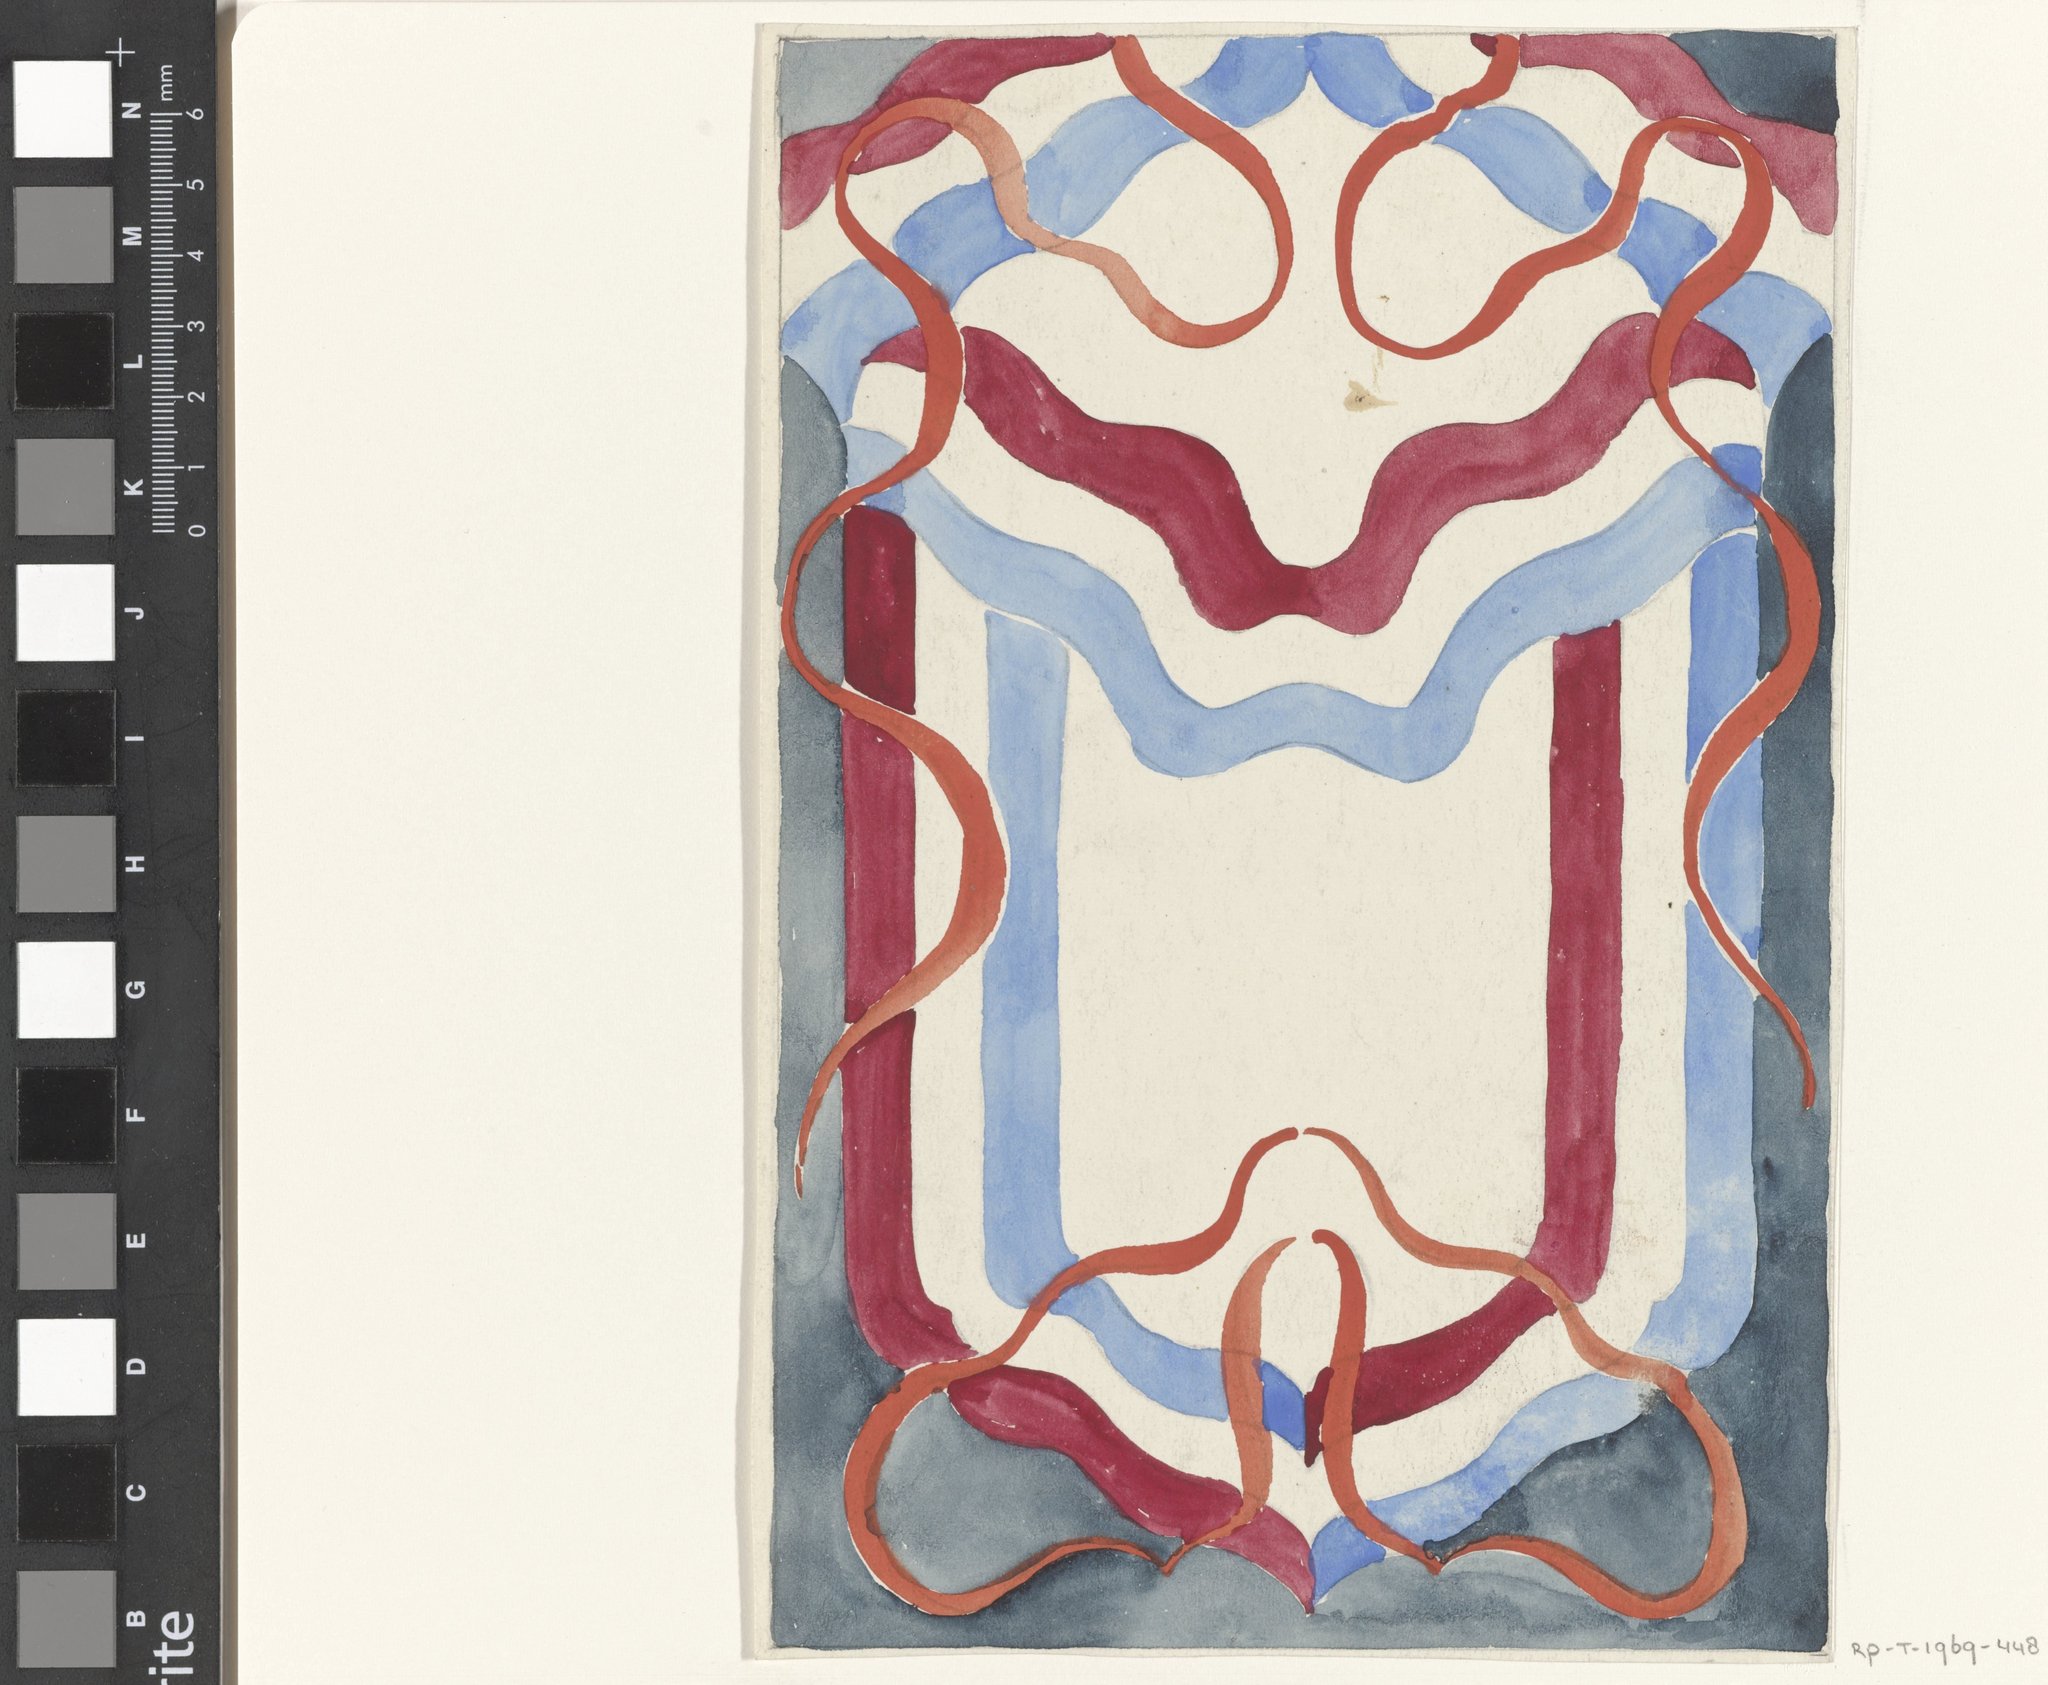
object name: drawing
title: Decoratief ontwerp met letter W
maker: carel adolph lion cachet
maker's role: draughtsman, print maker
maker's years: 1864-1945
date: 1874-1945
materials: ink, paper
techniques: pen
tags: initial